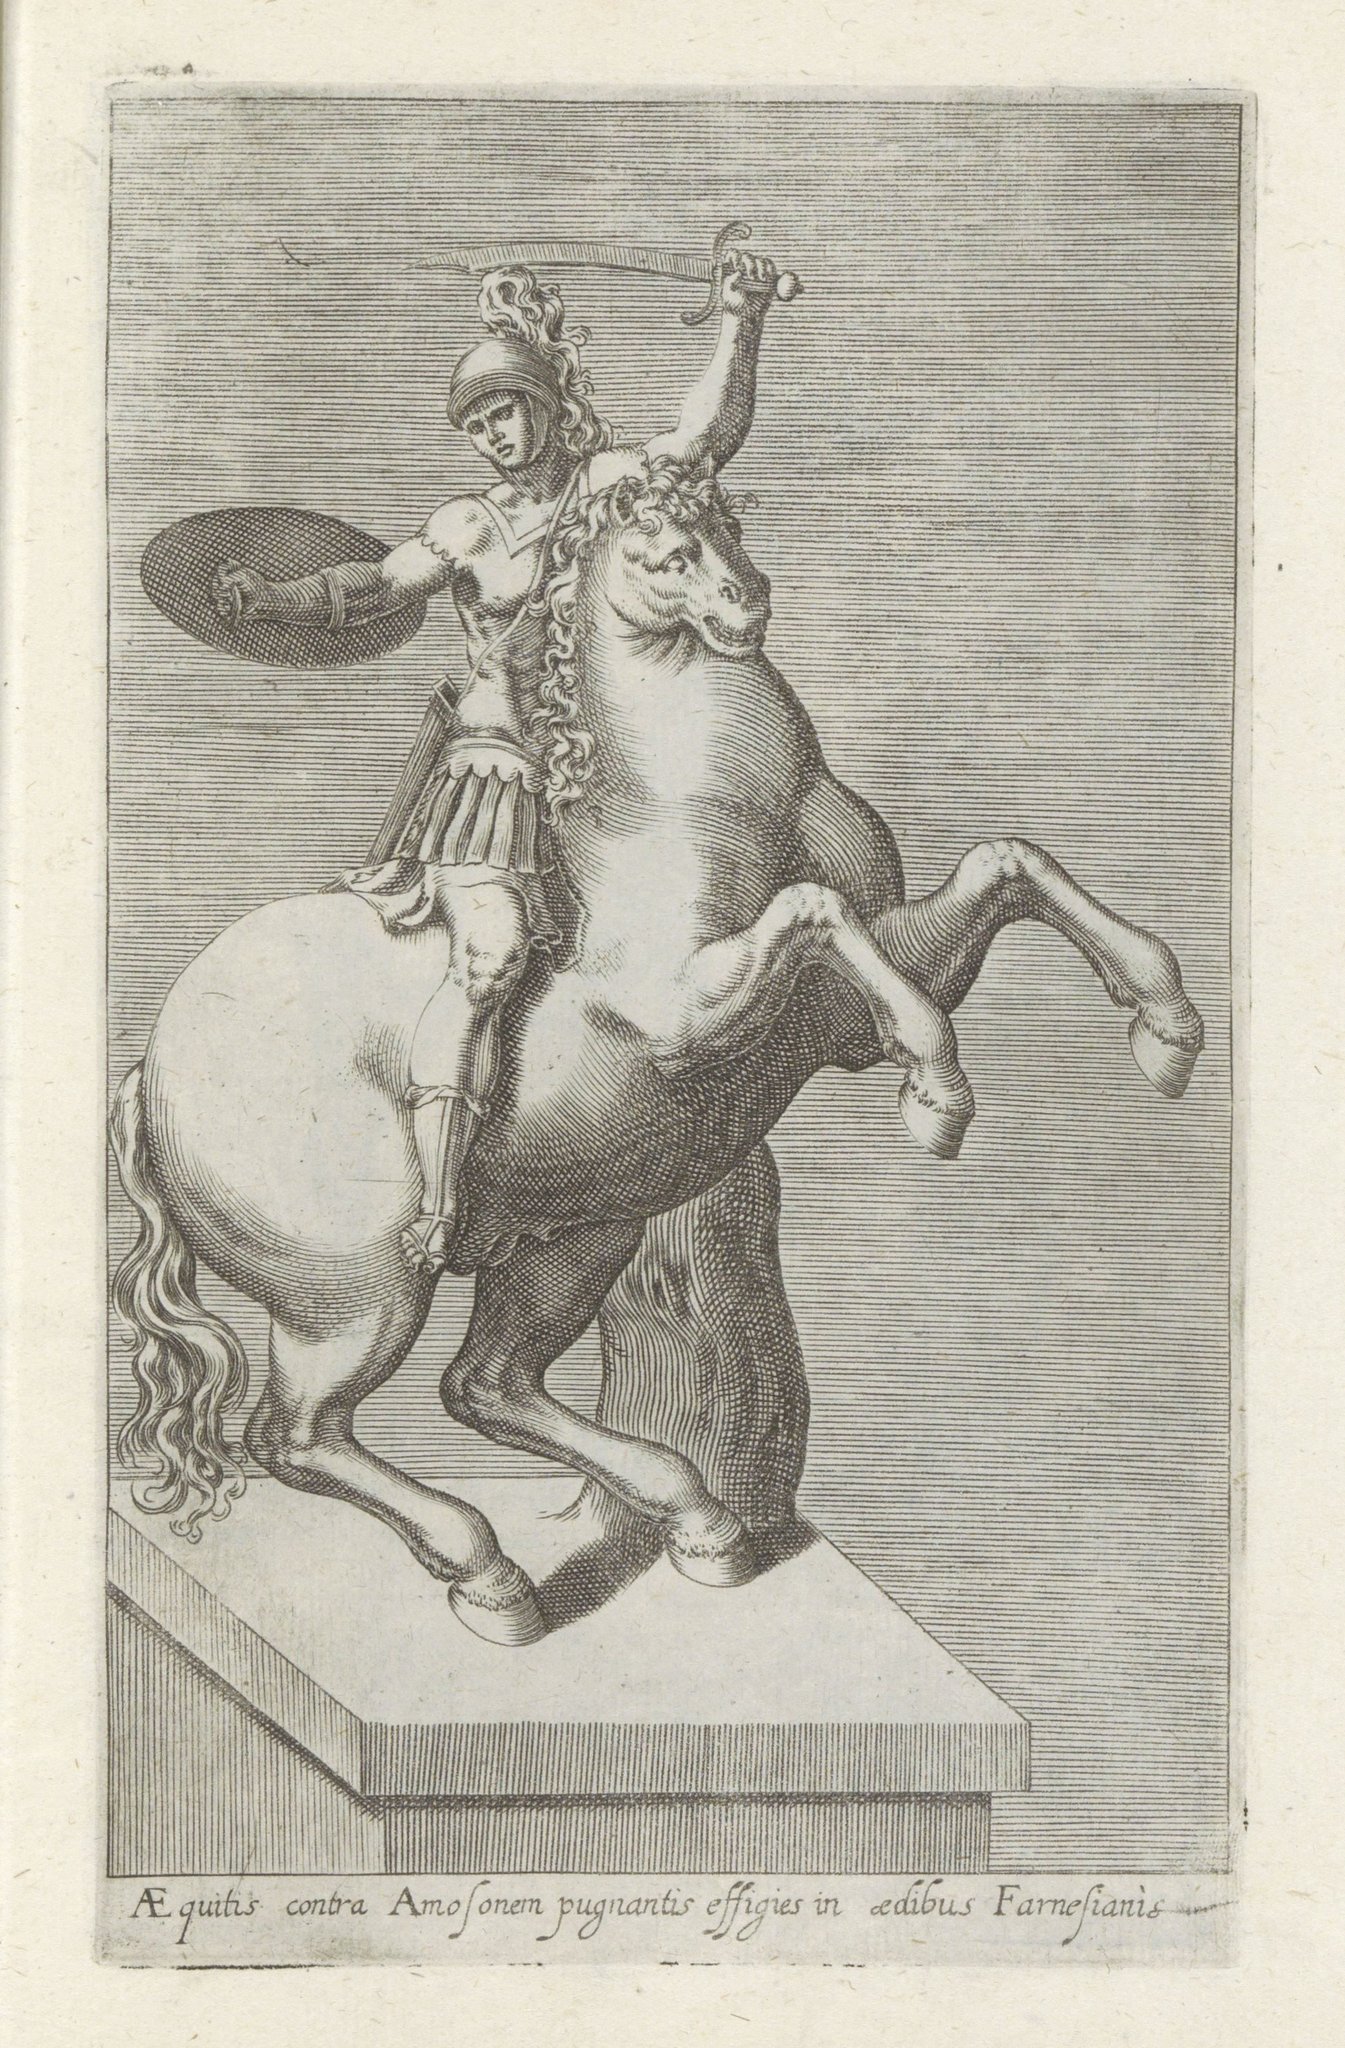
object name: print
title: Antieke sculpturen in Rome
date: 1584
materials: paper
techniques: engraving, intaglio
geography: rome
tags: piece of sculpture, reproduction of a piece of sculpture, the soldier; the soldier's life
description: Het beeld bevindt zich in het Museo archeologico Nazionale di Napoli. Deze prent maakt deel uit van een set van 79 prenten (+ titelprent) met voorstellingen van antieke sculpturen in Rome.